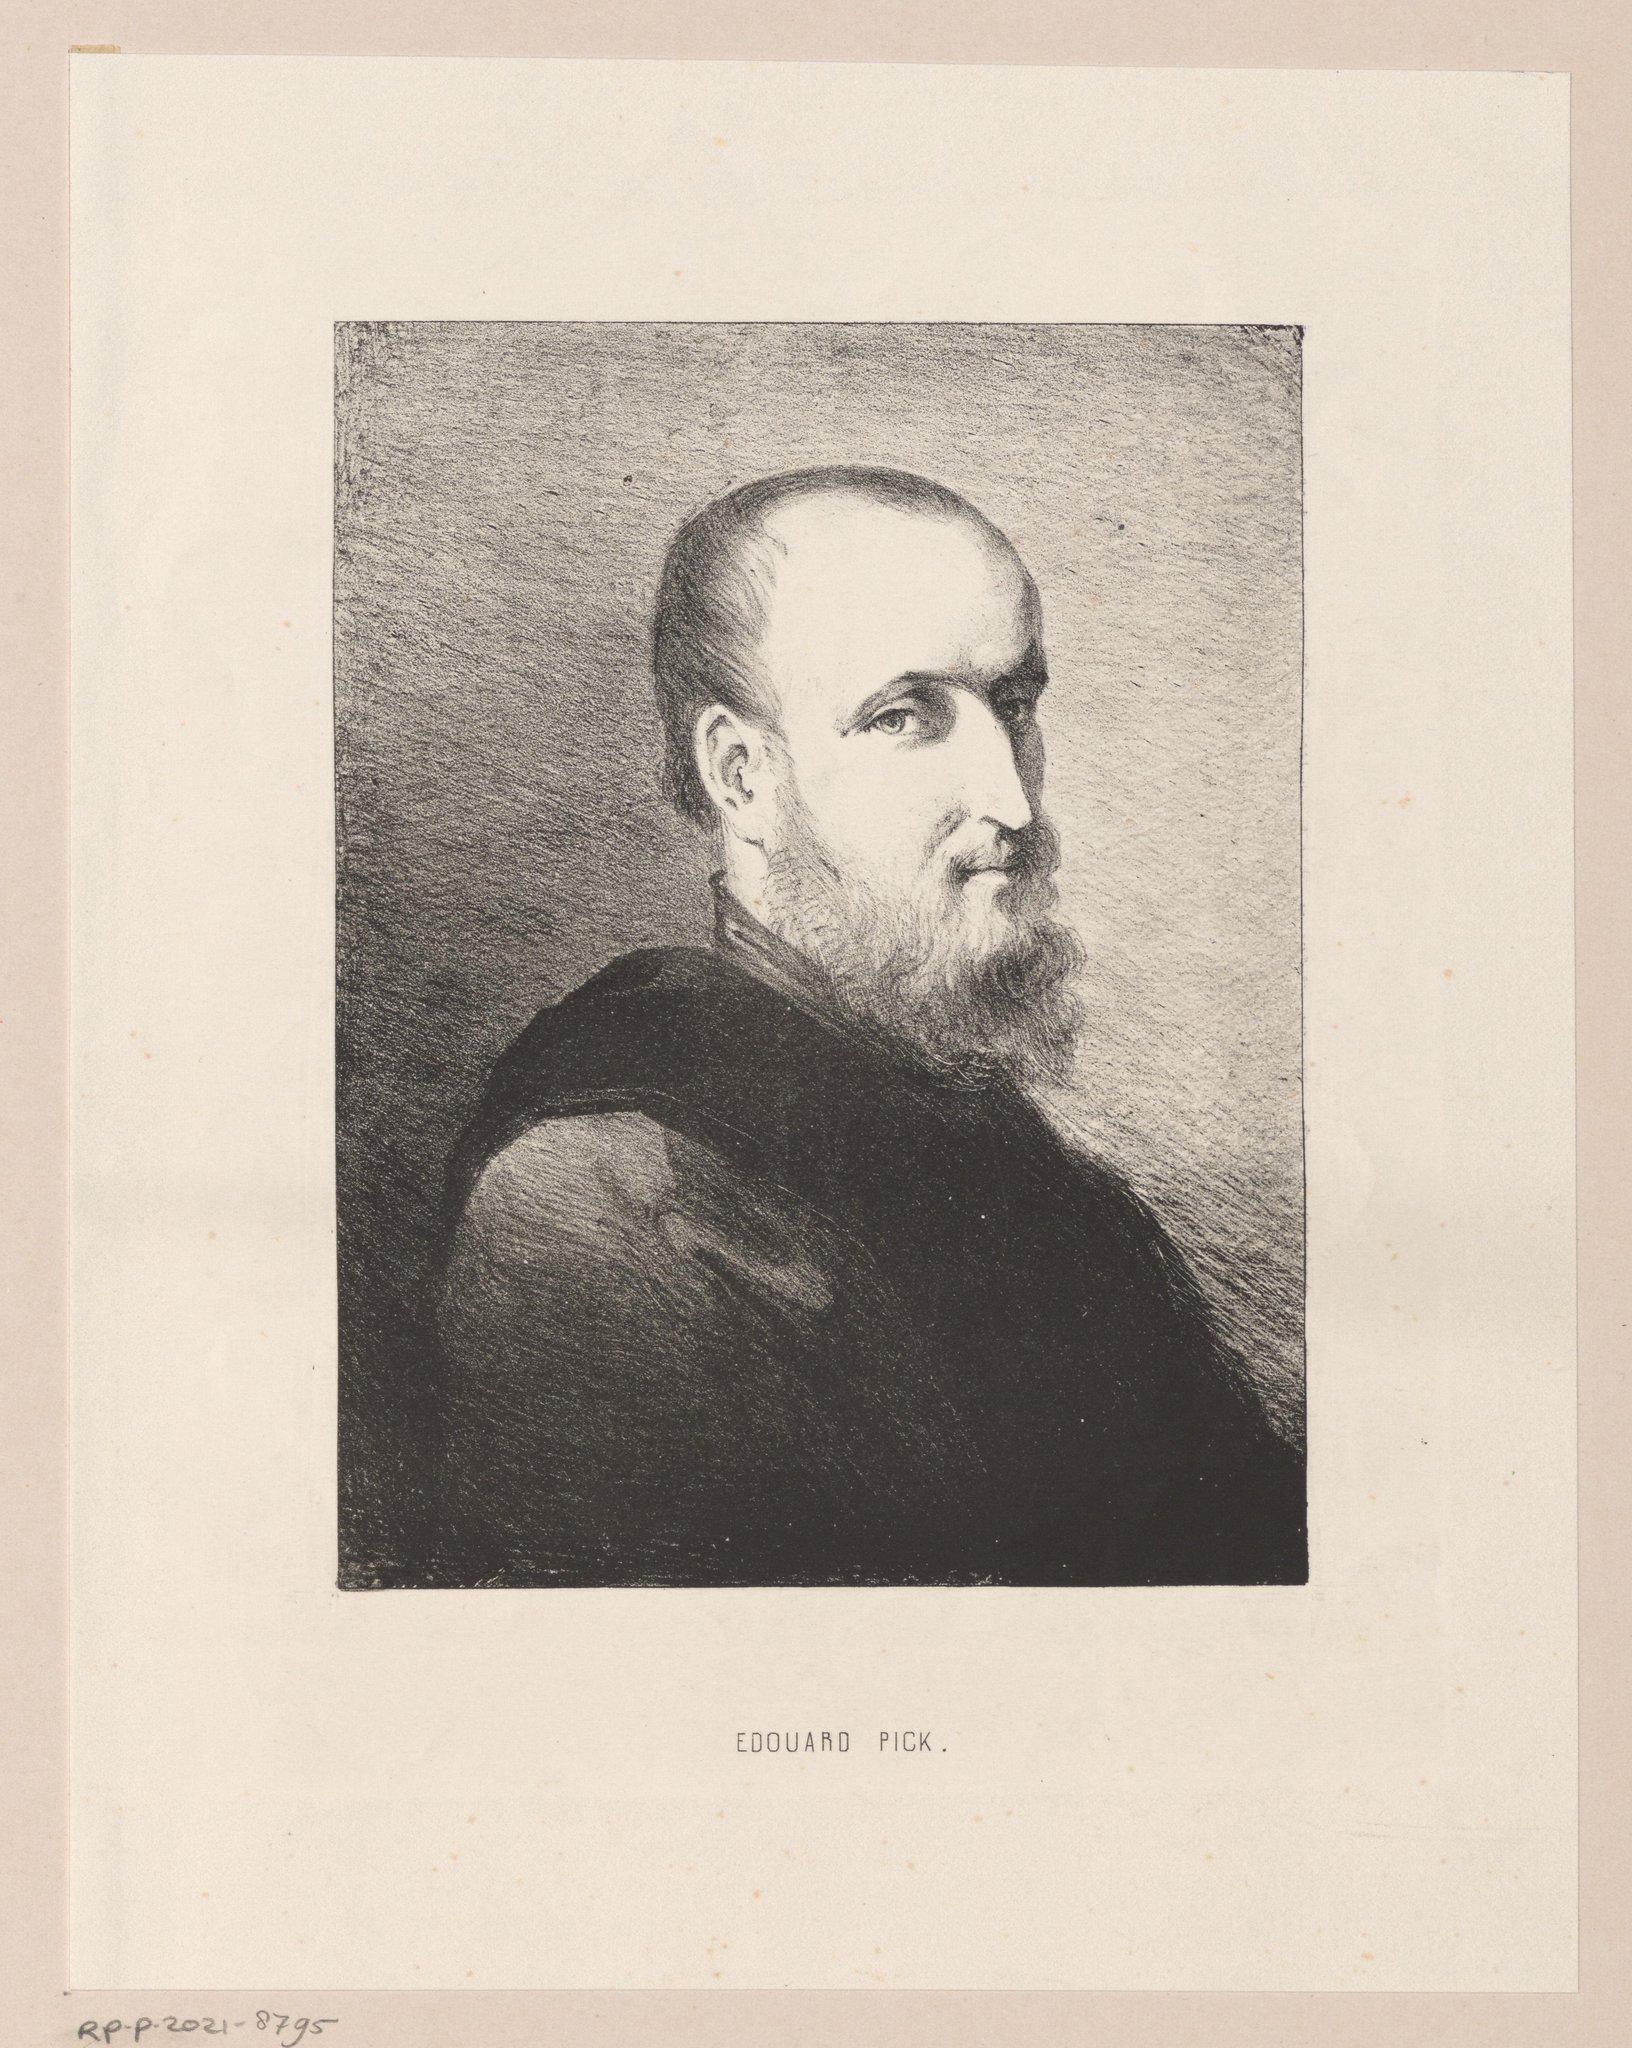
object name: print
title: Portret van Edouard Pick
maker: Anonymous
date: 1820-1899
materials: paper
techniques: lithograph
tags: adult man, historical persons